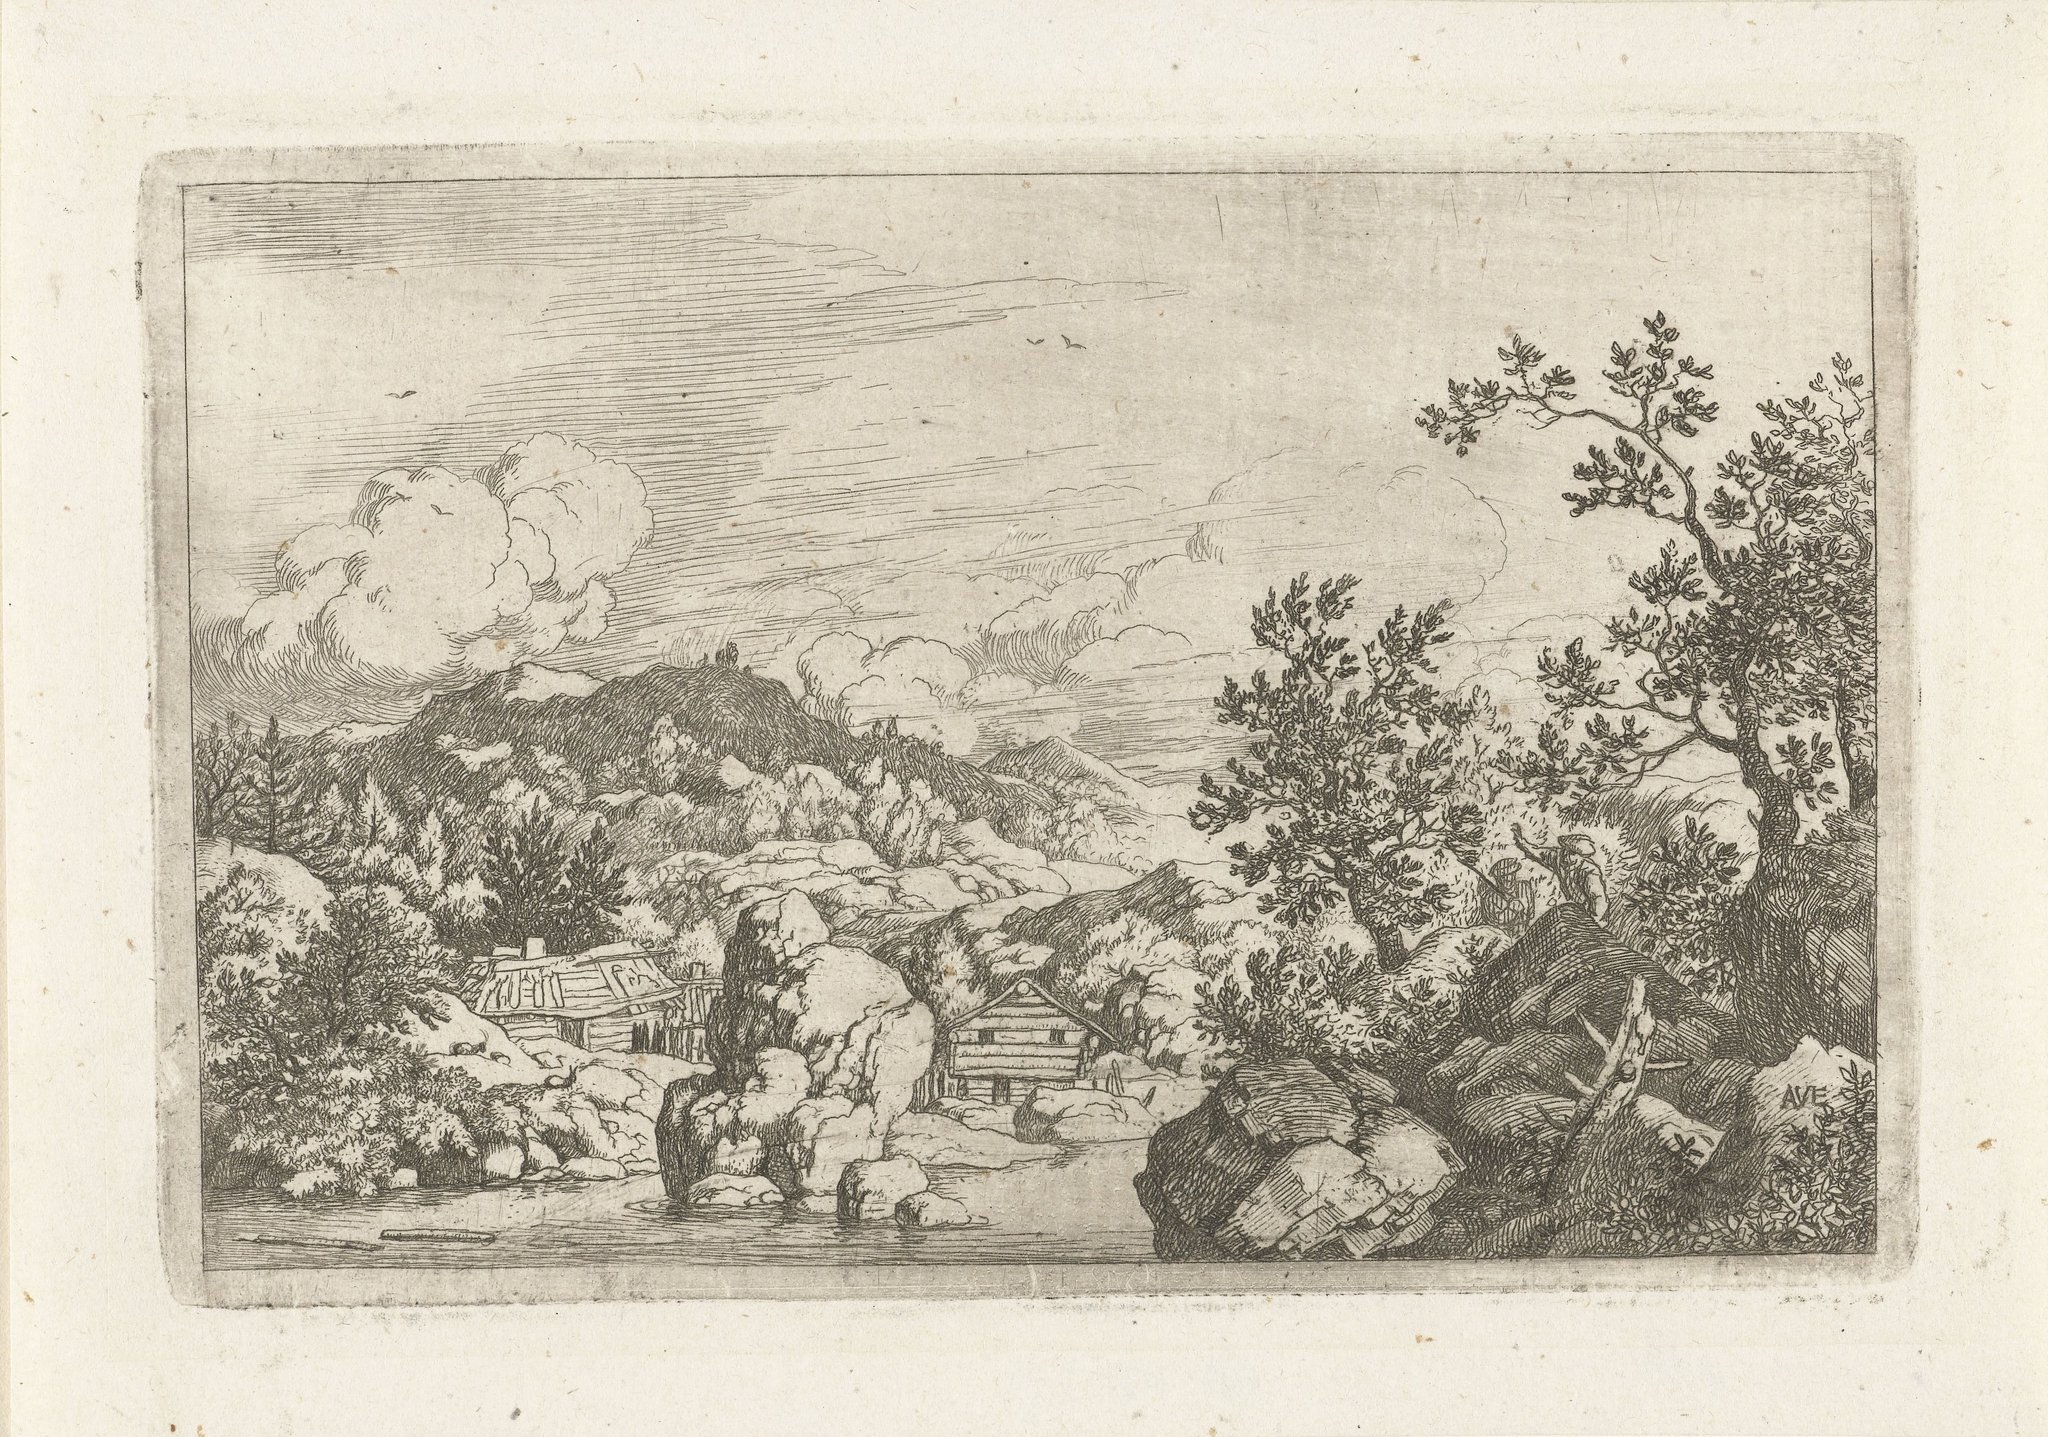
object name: print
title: Landschap met rots in een rivier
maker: allaert van everdingen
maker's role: draughtsman, painter, print maker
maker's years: 1621-1675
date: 1631-1675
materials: paper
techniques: etching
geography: netherlands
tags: river (+ landscape with figures, staffage)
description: Berglandschap met een rivier rondom een grote rots en op de oever enkele houten huizen. Tussen de bomen en rotsen op de voorgrond twee personen.